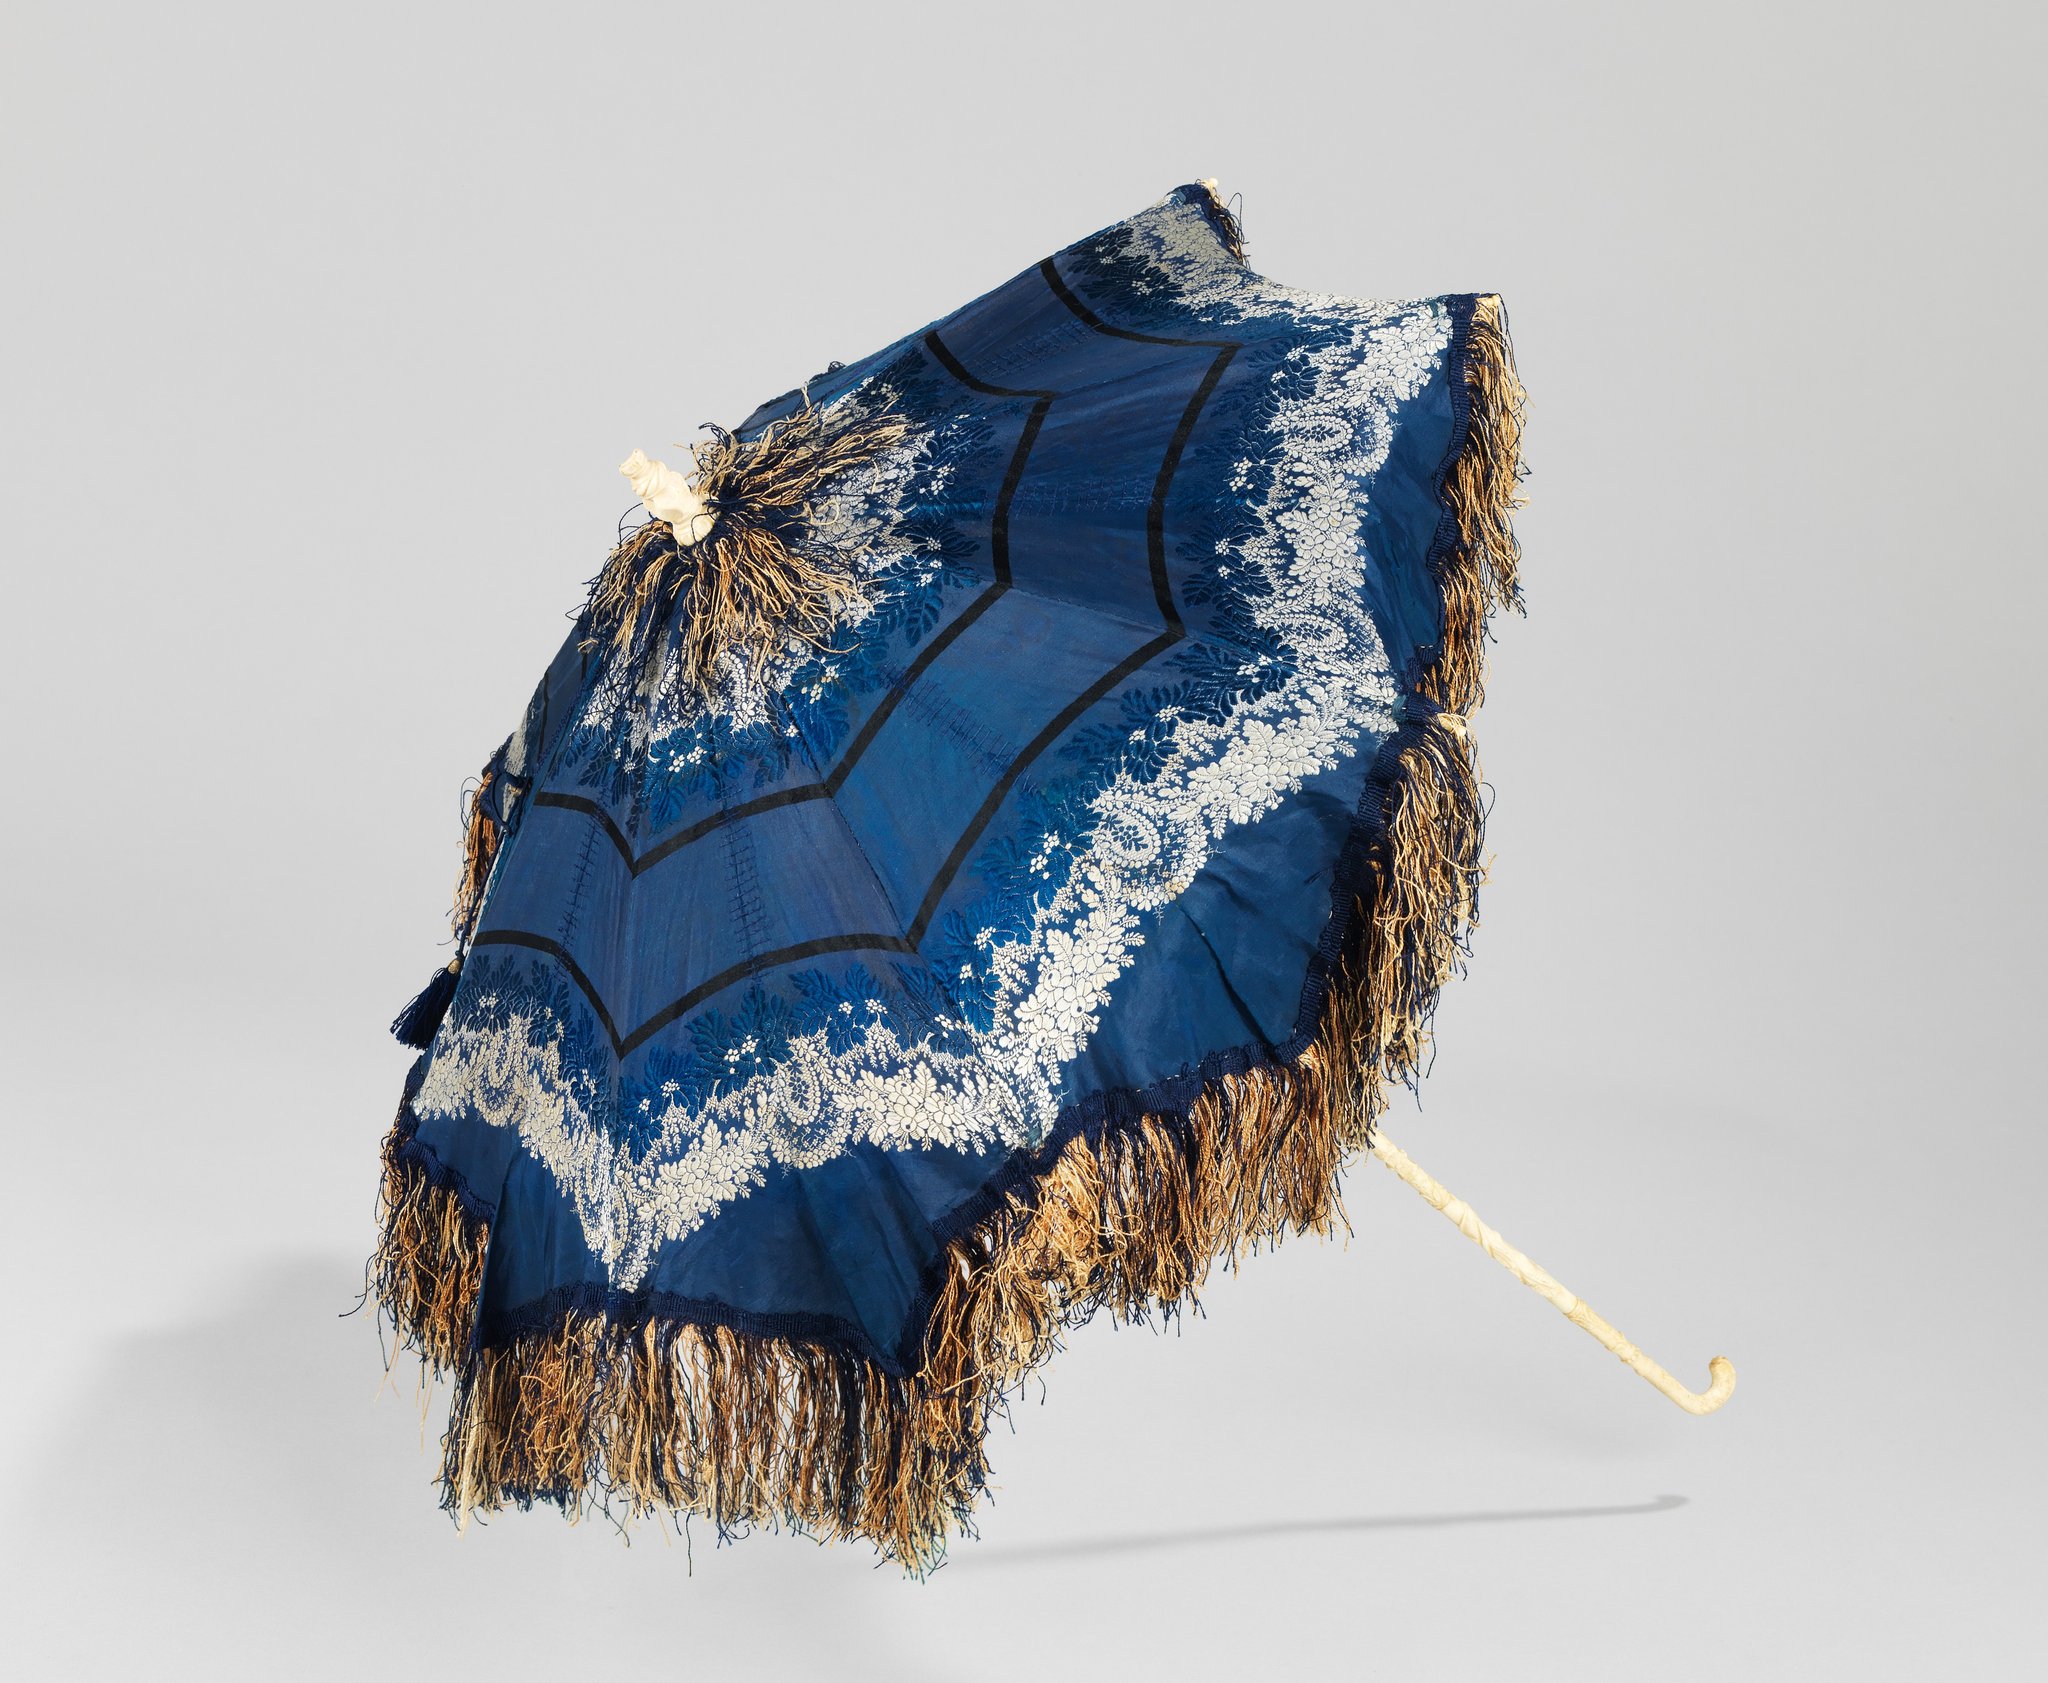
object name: parasol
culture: american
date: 1850-1859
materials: ivory, metal, silk, wood